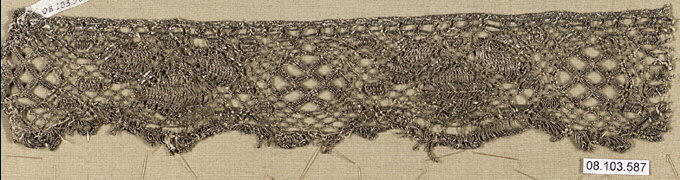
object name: piece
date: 1701-1900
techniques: lace